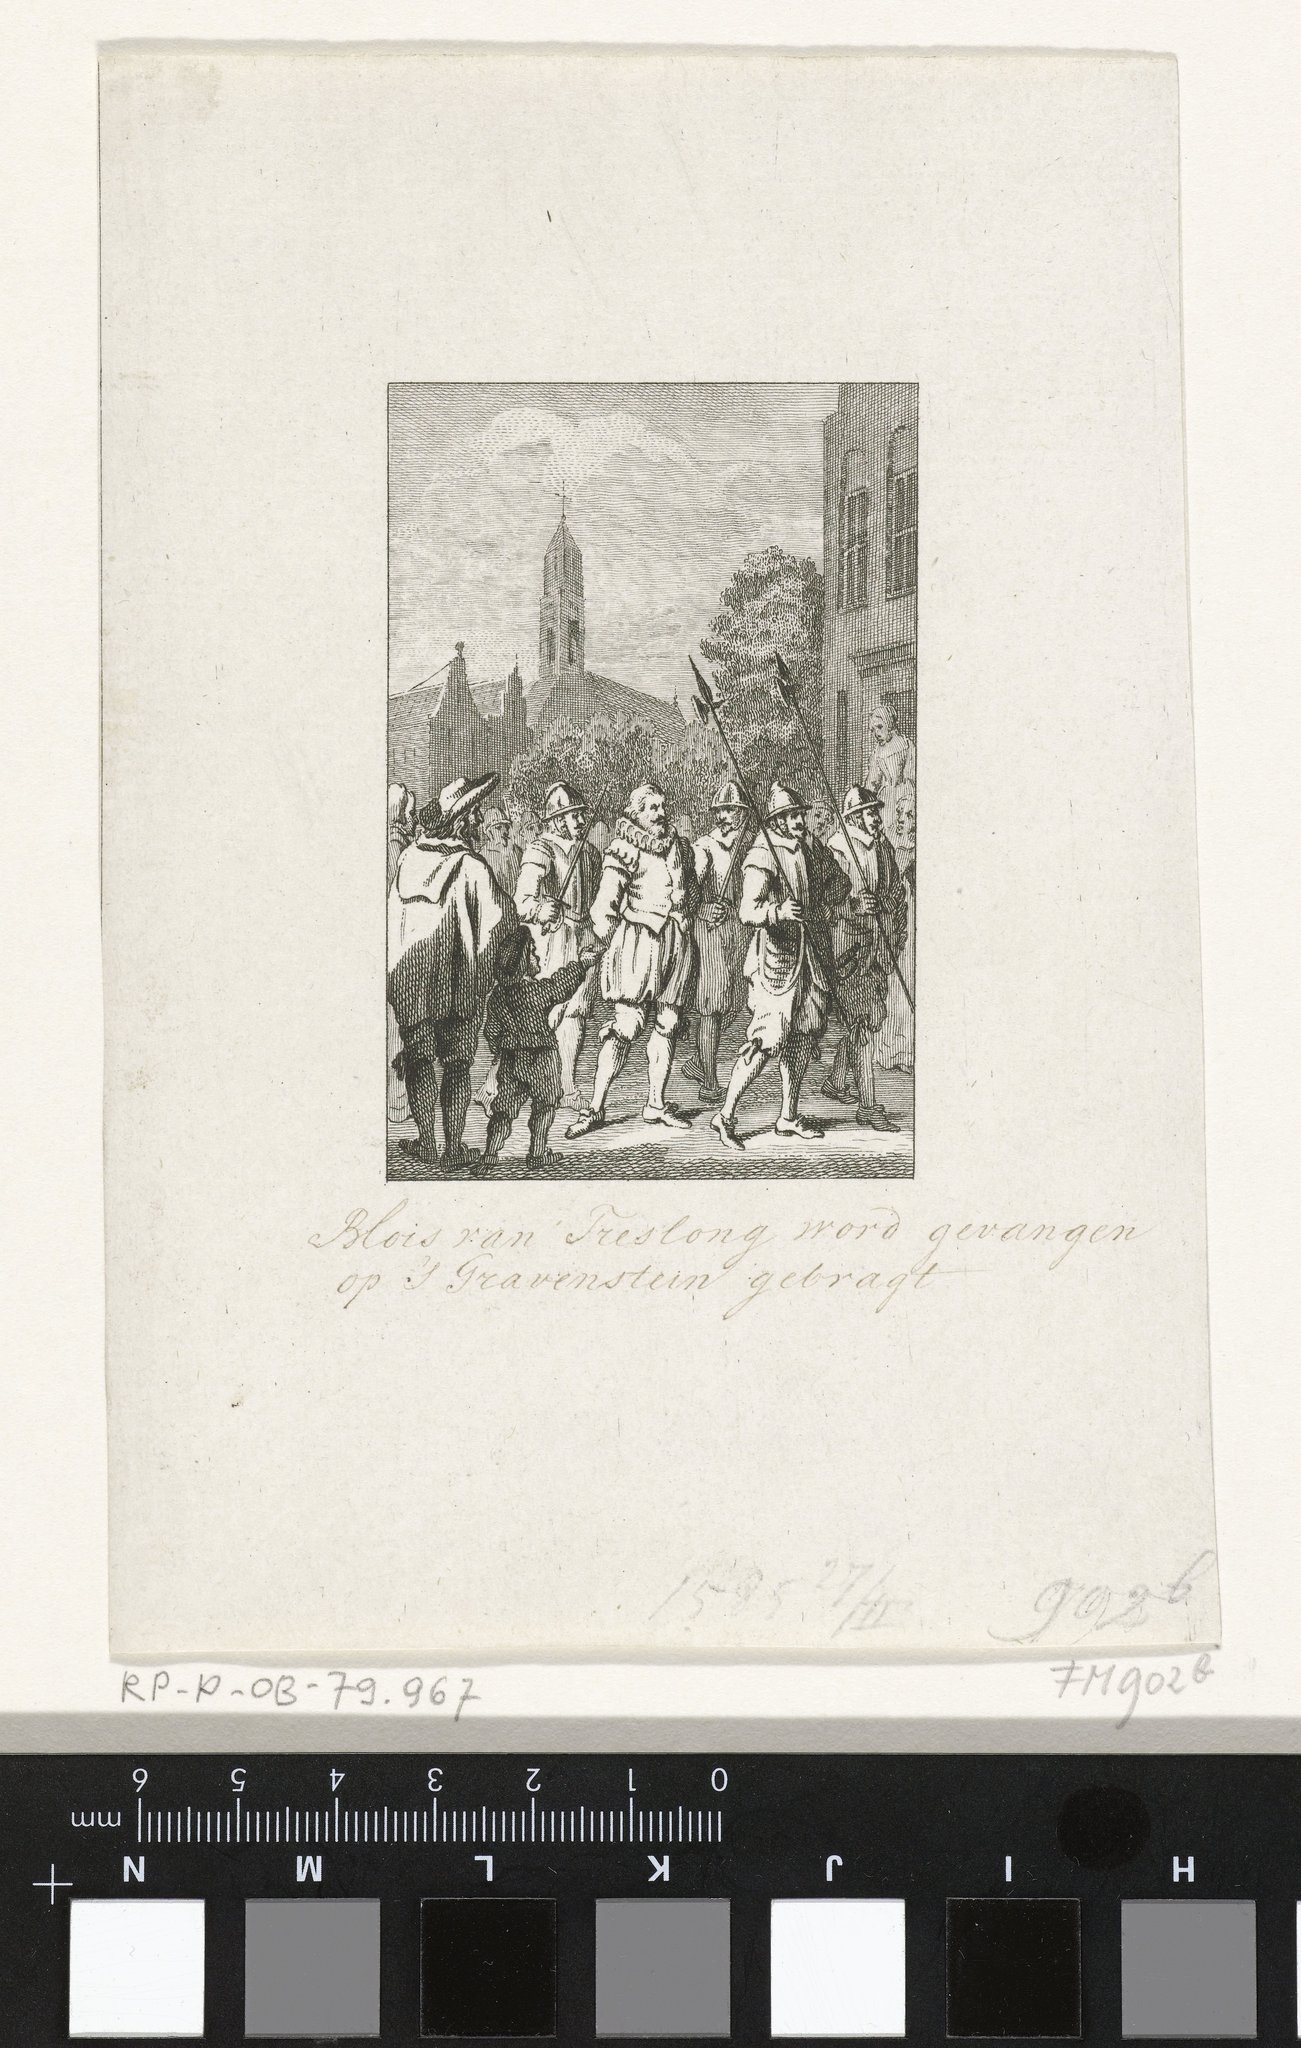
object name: history print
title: Admiraal Blois van Treslong gevangengenomen en naar het Gravensteen te Middelburg gebracht, 1585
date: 1780-1795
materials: paper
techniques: etching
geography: netherlands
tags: imprisonment, middelburg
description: Admiraal Blois van Treslong, beticht van corruptie en insubordinatie, wordt gevangengenomen en onder militaire escorte naar het Gravensteen te Middelburg gebracht, 27 februari 1585.